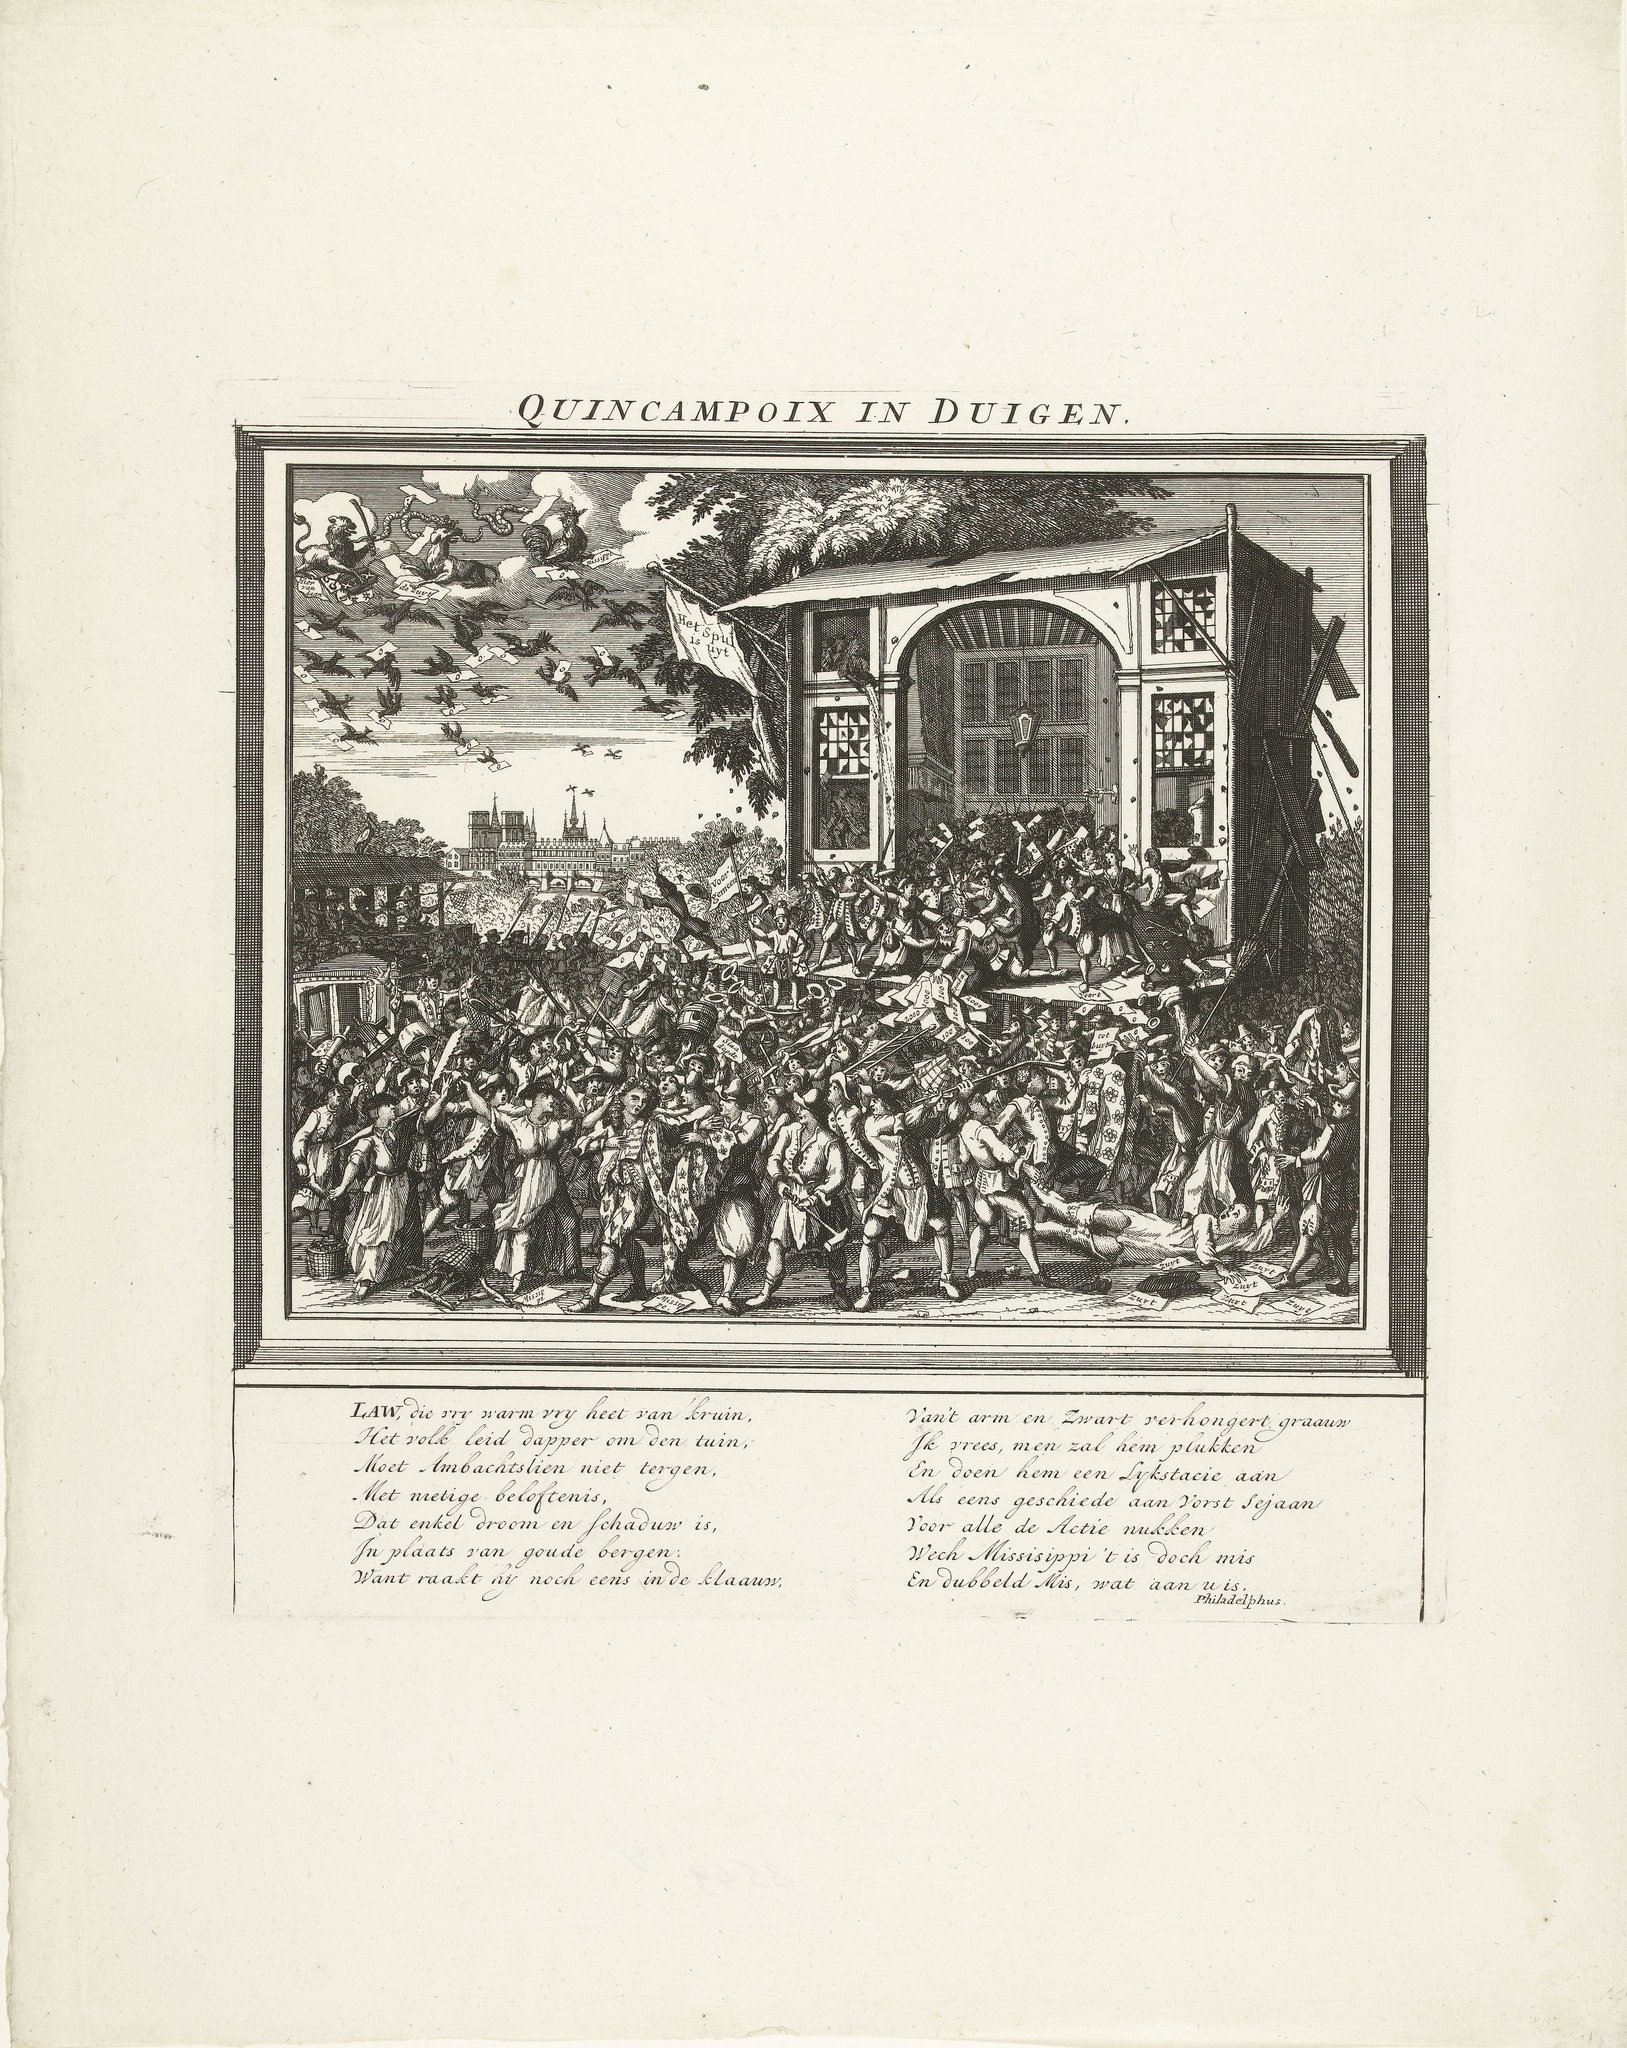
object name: cartoon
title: Quincampoix in duigen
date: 1720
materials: paper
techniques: etching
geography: northern netherlands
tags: financial panic, street-fights, riots, paris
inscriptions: collector's mark: Lugt 2228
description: Spotprent op de windhandel van John Law, 1720. Een theater van waaruit de acties worden verkocht wordt door een woedende menigte met stenen bekogeld. Op de voorgrond wordt Law aangevallen door de menigte, in de verte Parijs. In het onderschrift een vers in twee kolommen door Philadelphus. Prent 14 in de serie Het Groote Tafereel der Dwaasheid met spotprenten op de Windhandel of Actiehandel van 1720.